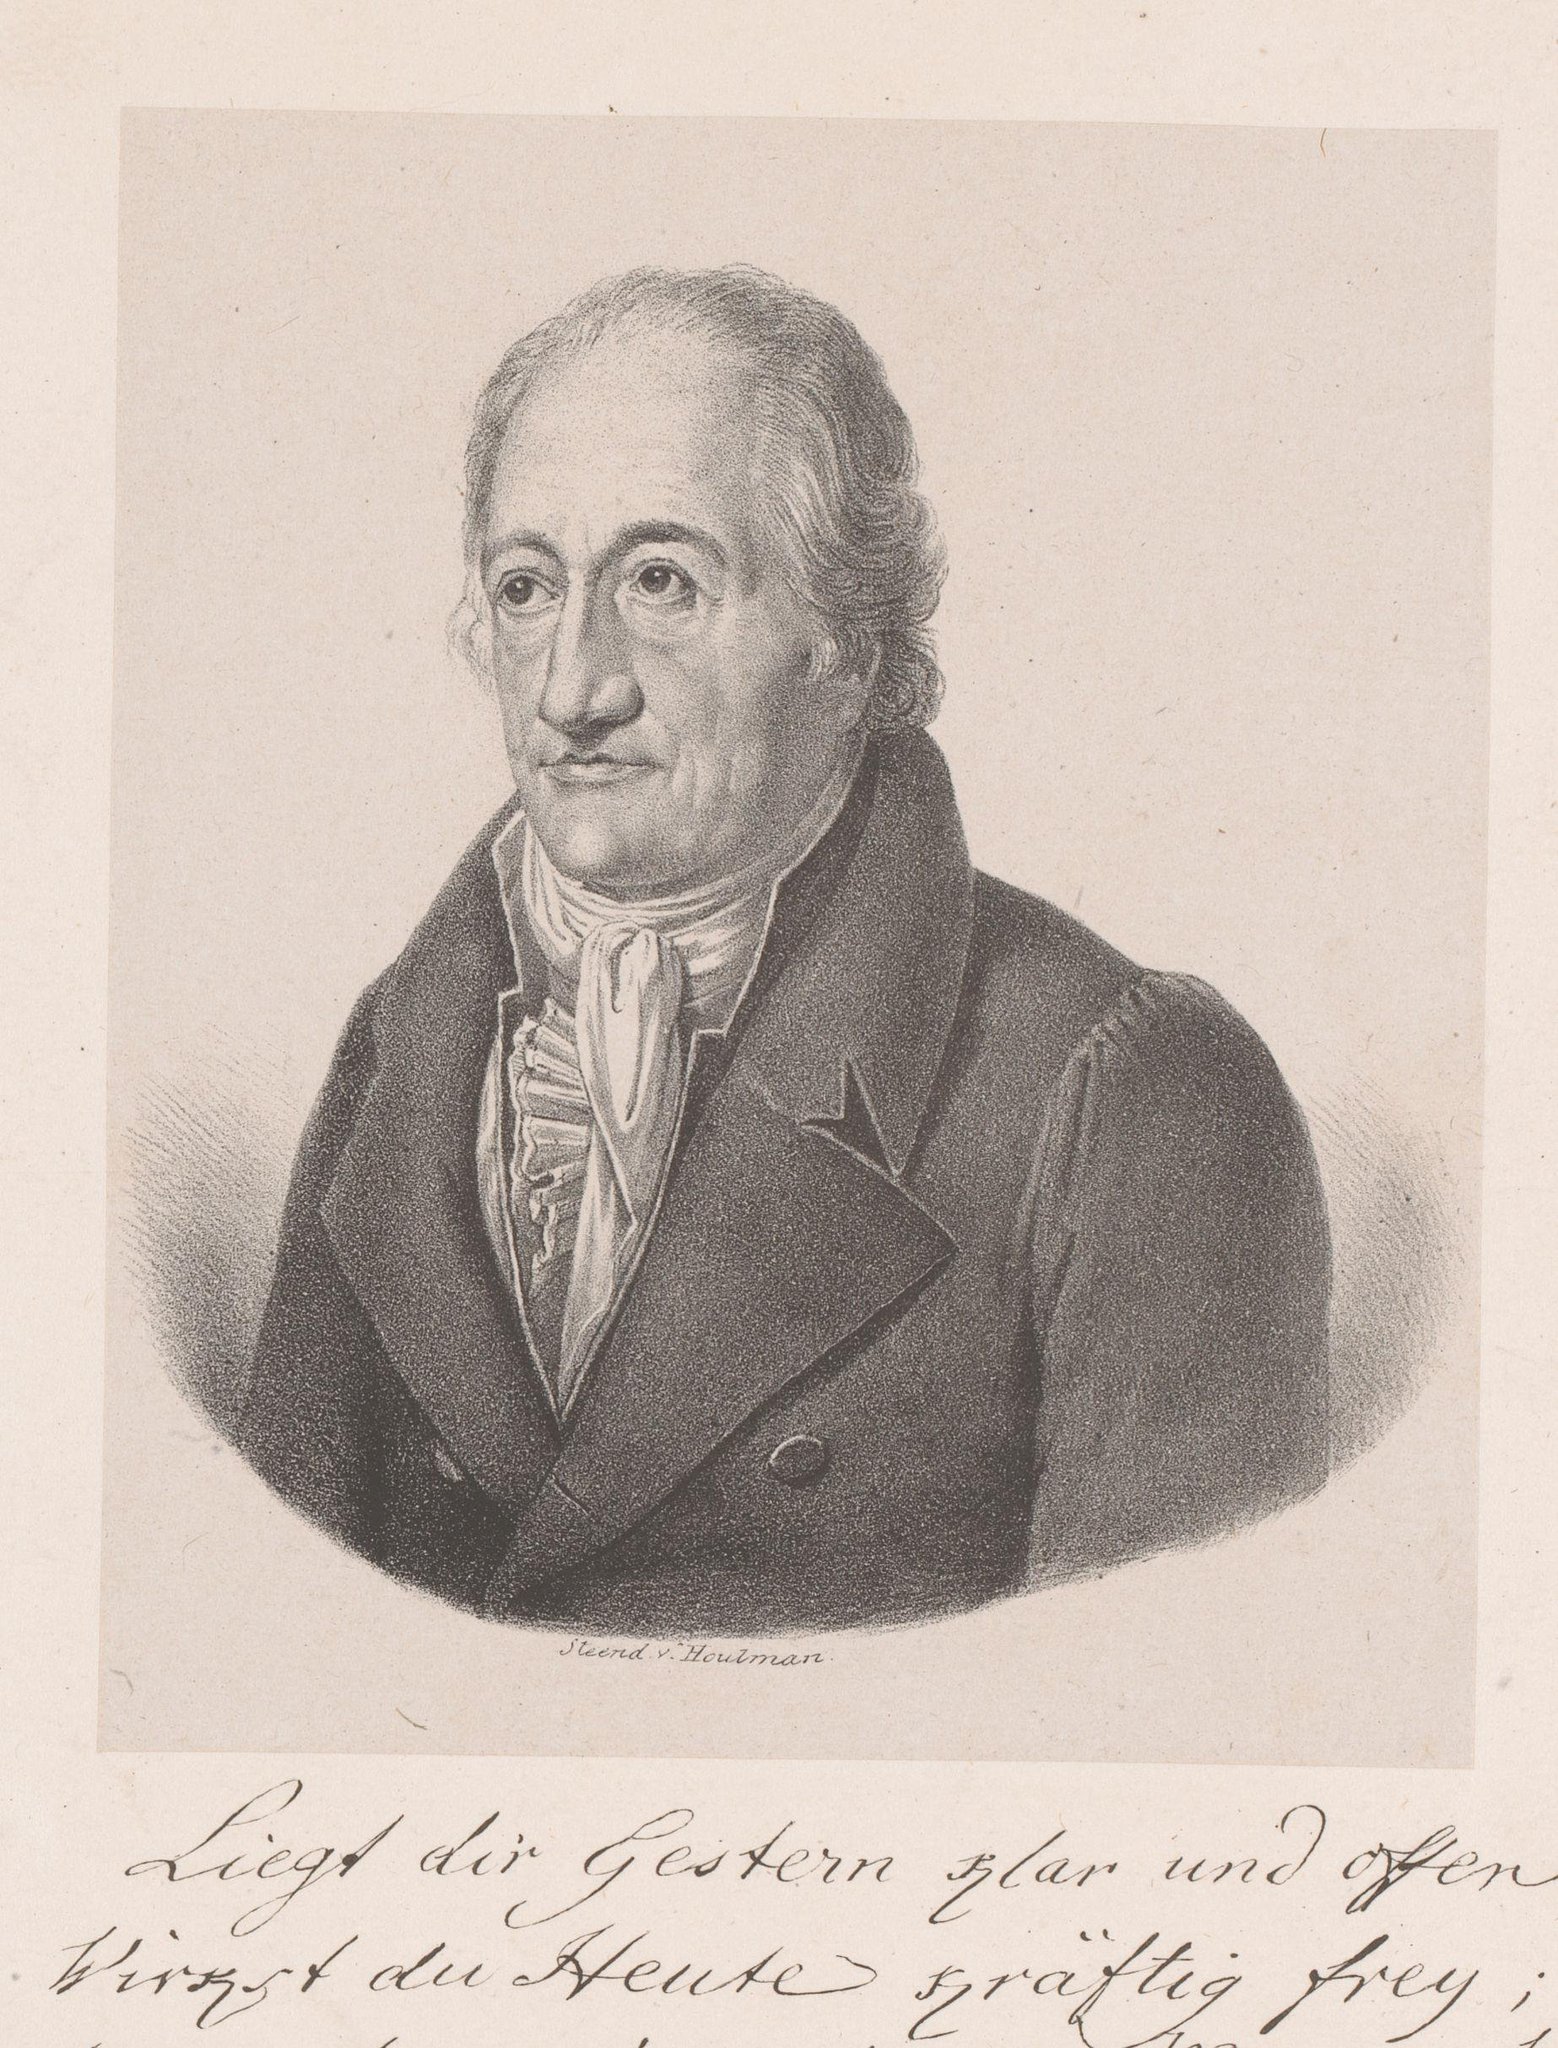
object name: print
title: Portret van Johann Wolfgang von Goethe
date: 1832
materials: paper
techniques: lithograph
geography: utrecht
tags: draughtsman, johann wolfgang von goethe, historical persons (+ (full) bust portrait)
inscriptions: collector's mark: Lugt 2228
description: Onder het portret een vierregelig gedicht van zijn hand en zijn signatuur.